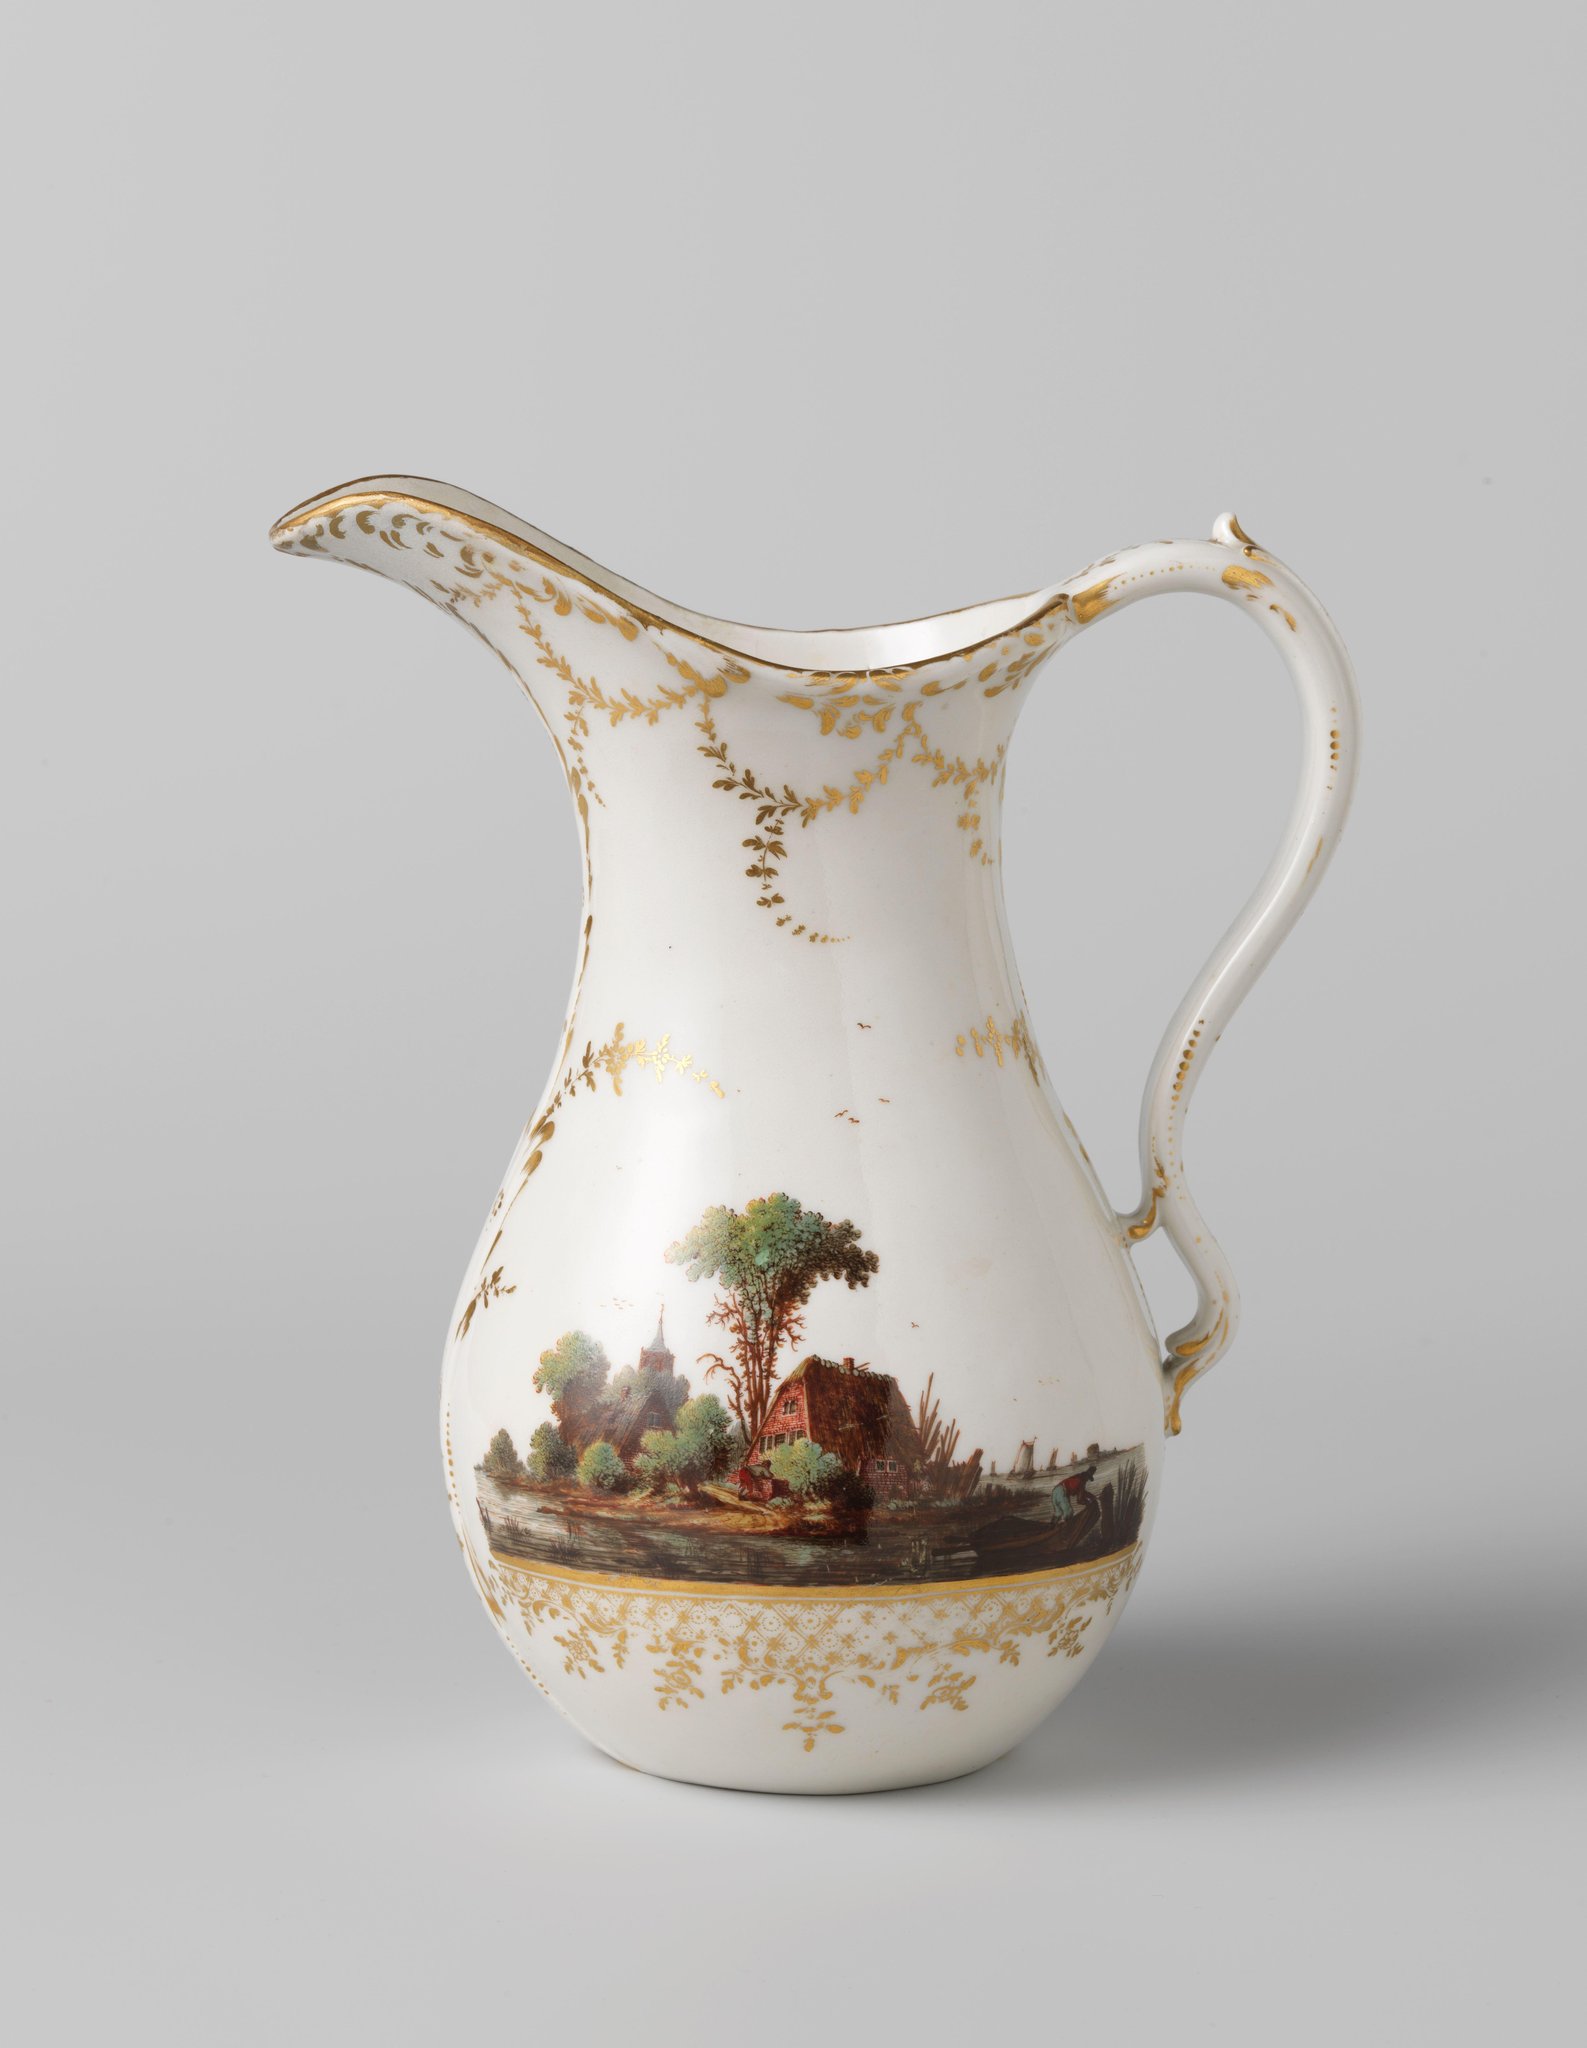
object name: pitcher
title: Lampetkan, beschilderd met een rivierlandschap met boerderij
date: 1778-1782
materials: porcelain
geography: loosdrecht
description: Ewer. Porcelain. Loosdrecht, c. 1778 - 1782. Factory of Joannes de Mol.